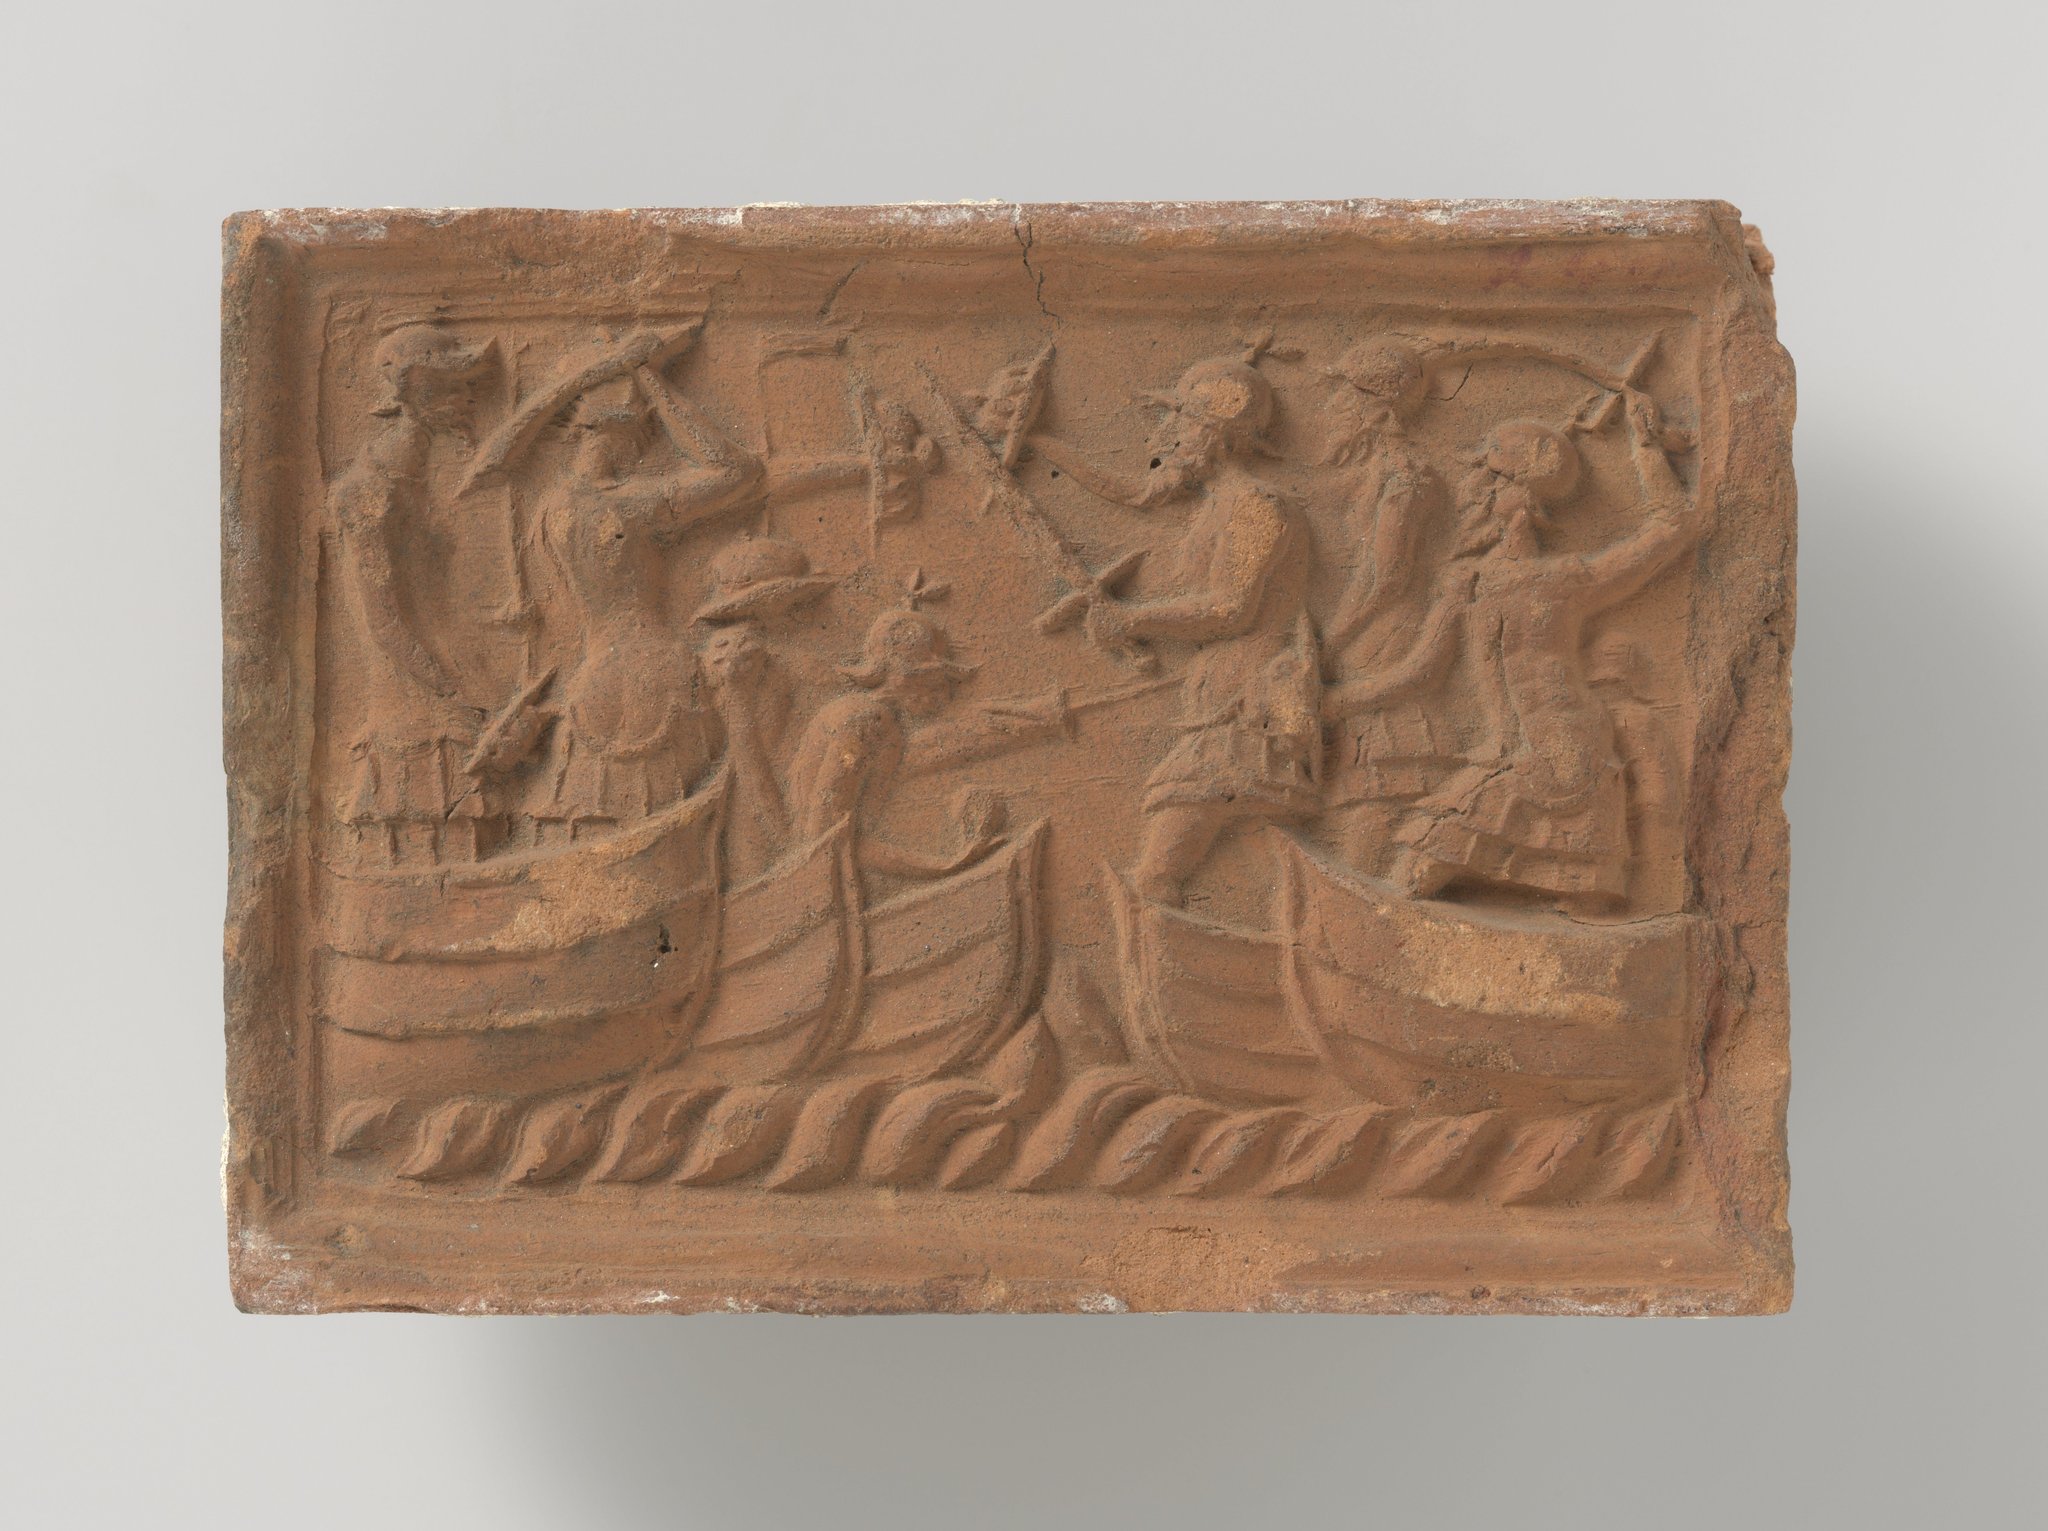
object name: hearthstone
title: Zeegevecht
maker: Anonymous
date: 1500-1600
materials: earthenware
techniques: printing, firing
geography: southern netherlands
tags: battle (+ naval force)